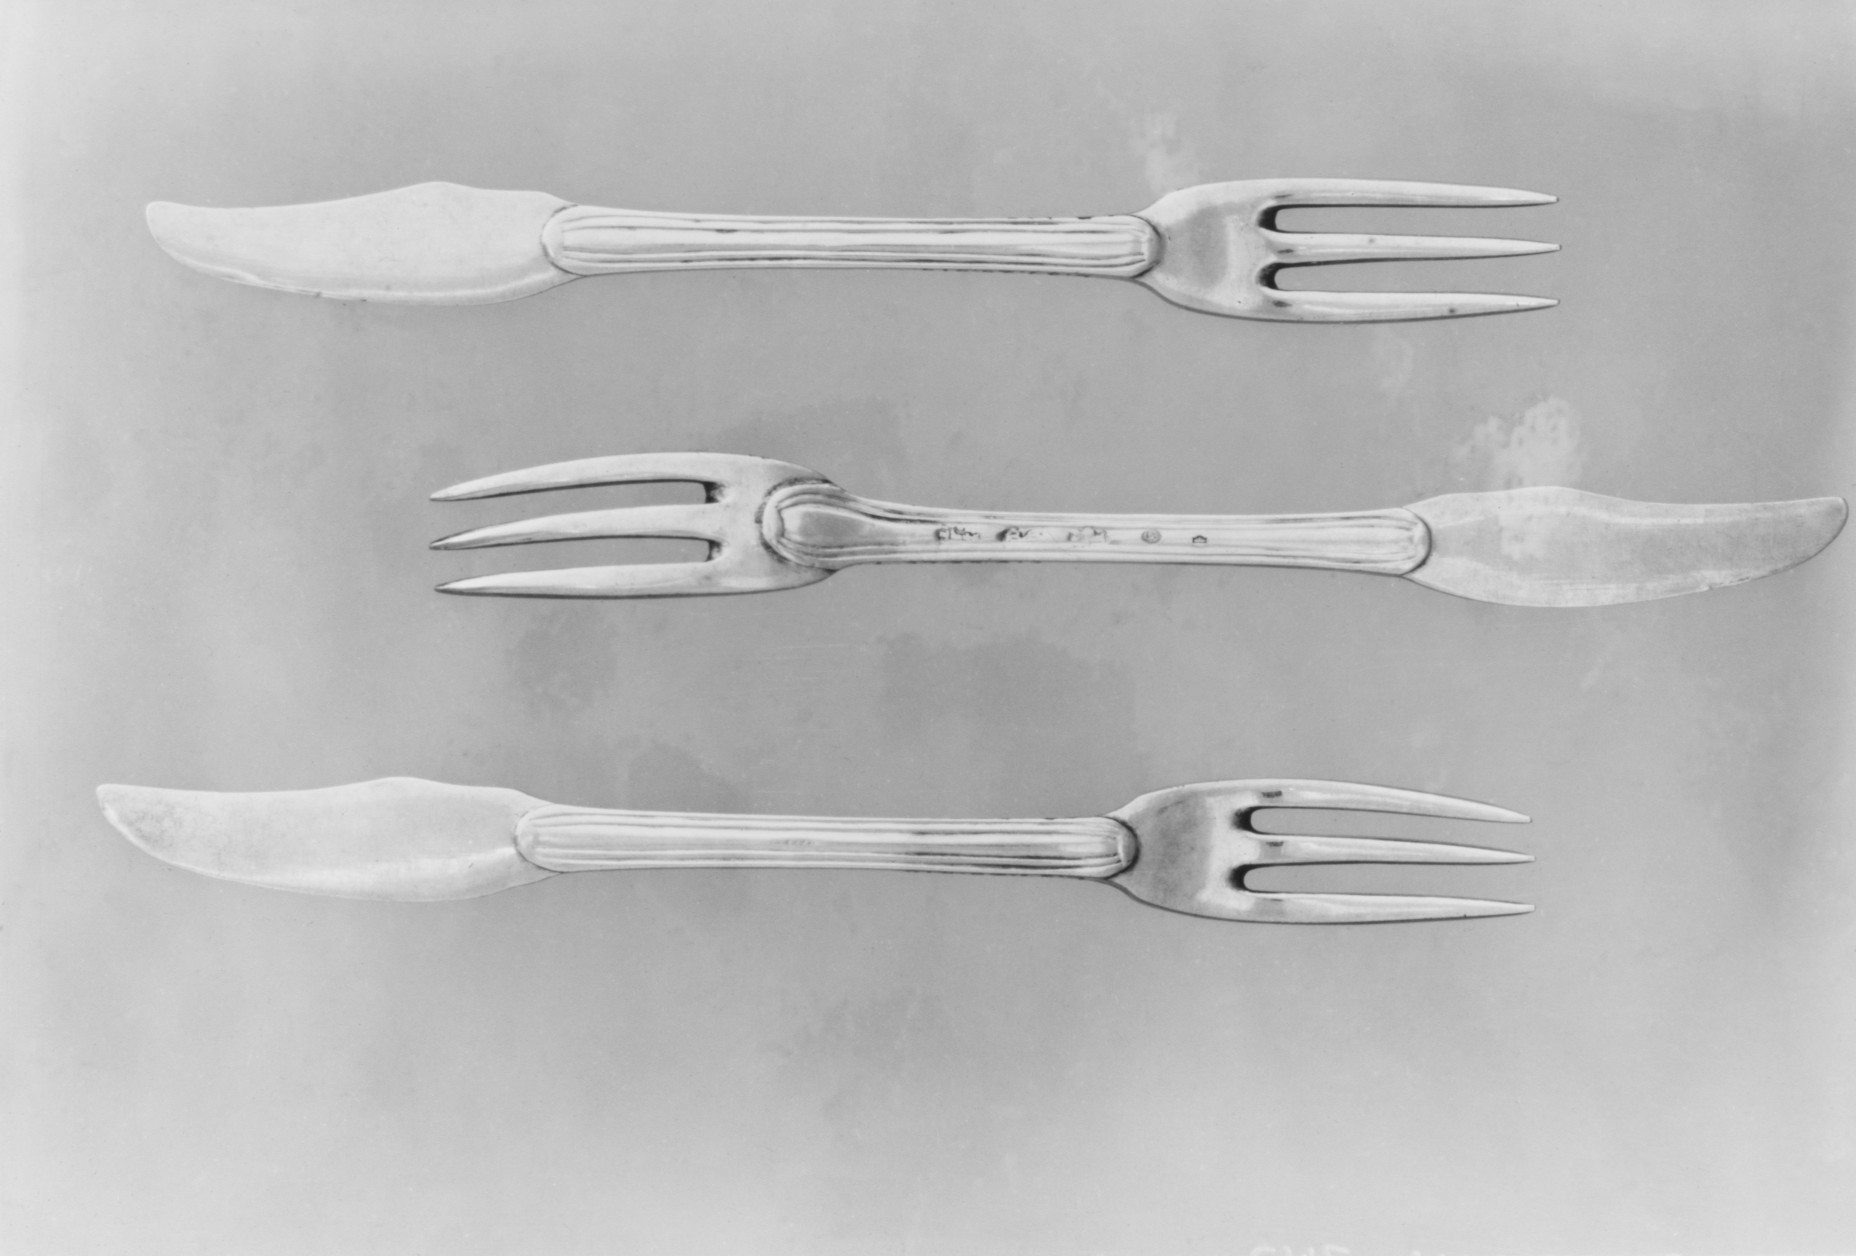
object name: fork with knife handle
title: Fork with knife handle (one of six)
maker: louis-antoine taillepied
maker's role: maker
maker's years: 1734-1834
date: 1778-1779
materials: silver